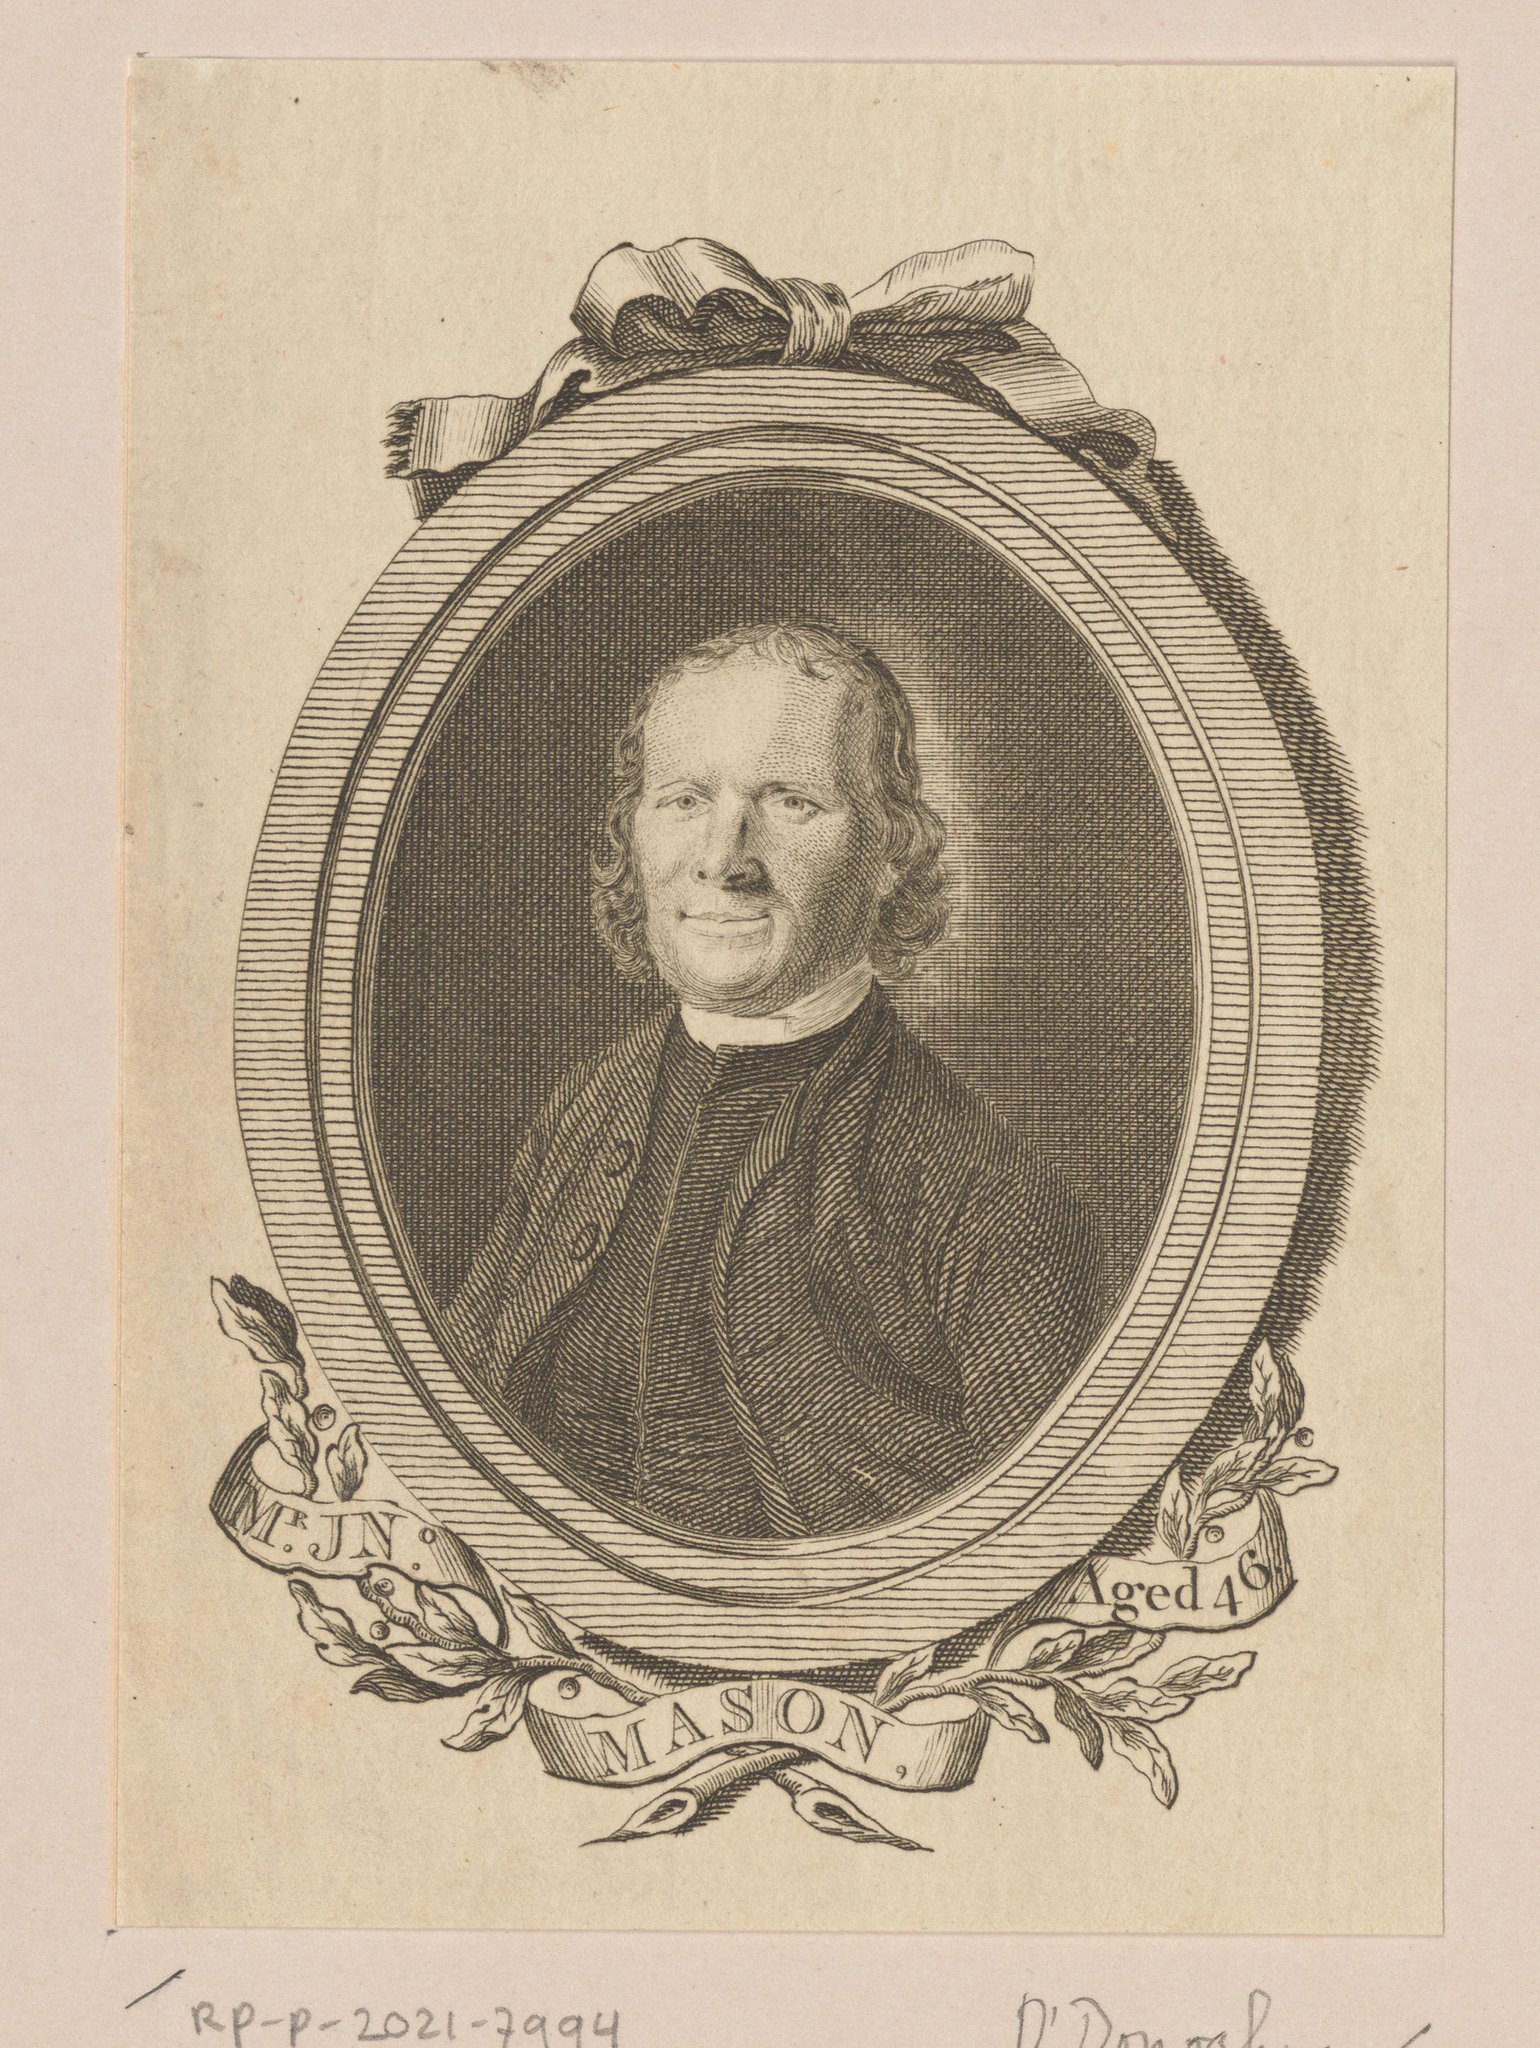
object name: print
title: Mr. JN. Mason Aged 46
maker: Anonymous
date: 1800-1850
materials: paper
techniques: engraving, etching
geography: england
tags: ornament ~ medallion, historical persons